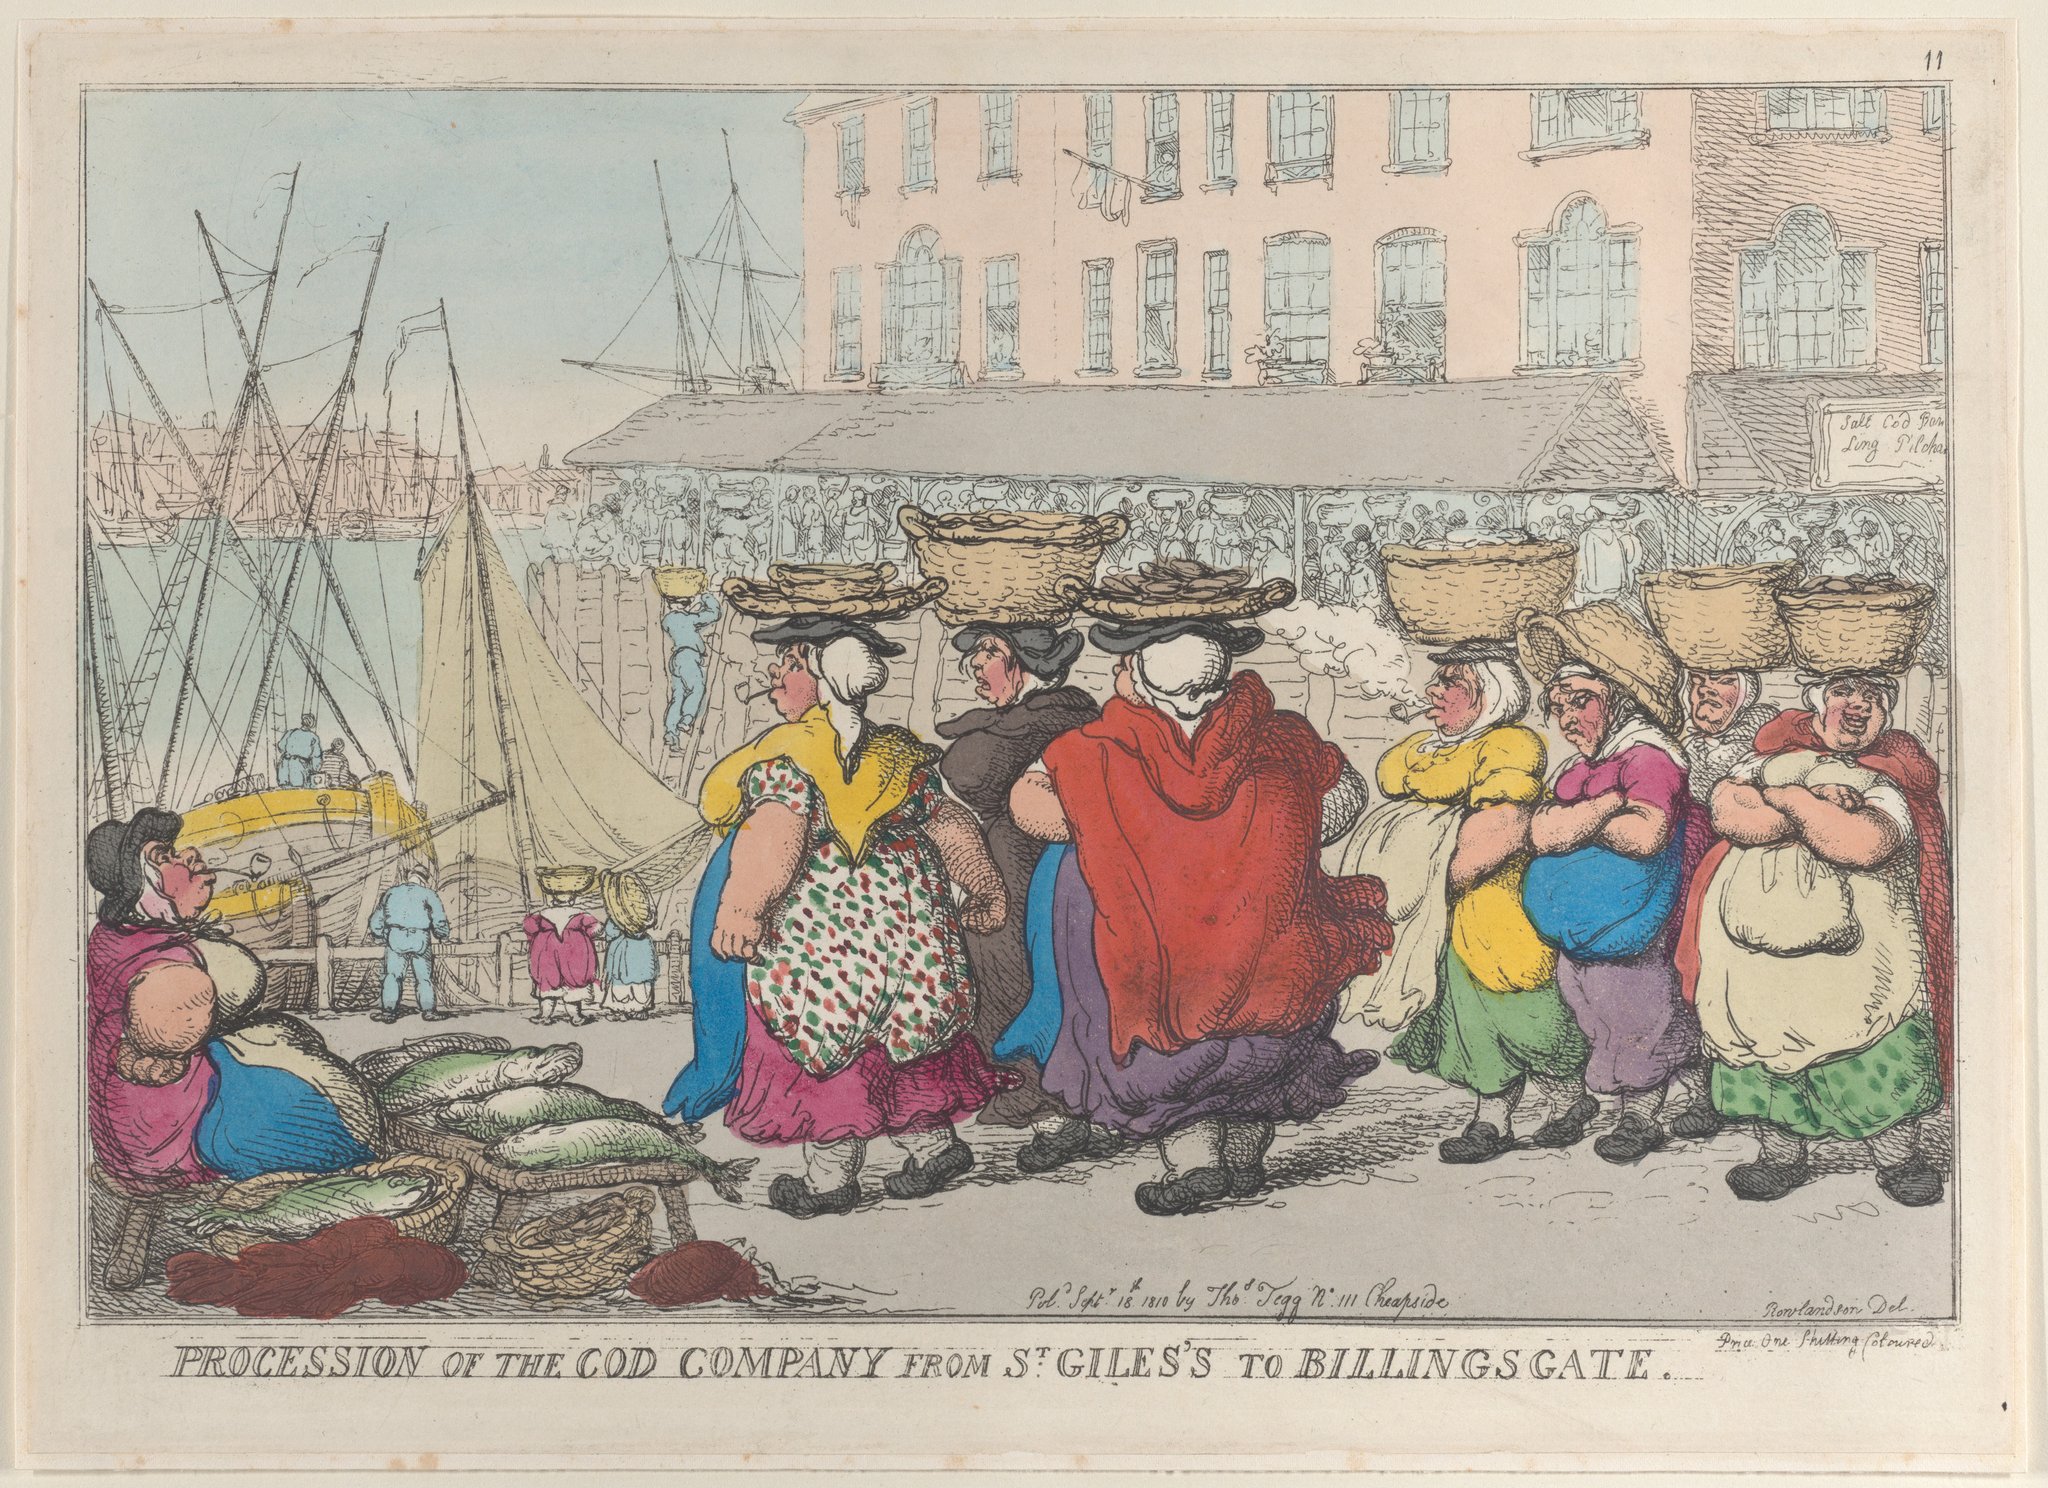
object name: print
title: Procession of the Cod Company from St. Giles's to Billingsgate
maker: thomas rowlandson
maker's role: artist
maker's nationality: british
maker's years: 1757-1827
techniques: etching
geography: london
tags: satire,women,smoking,ships